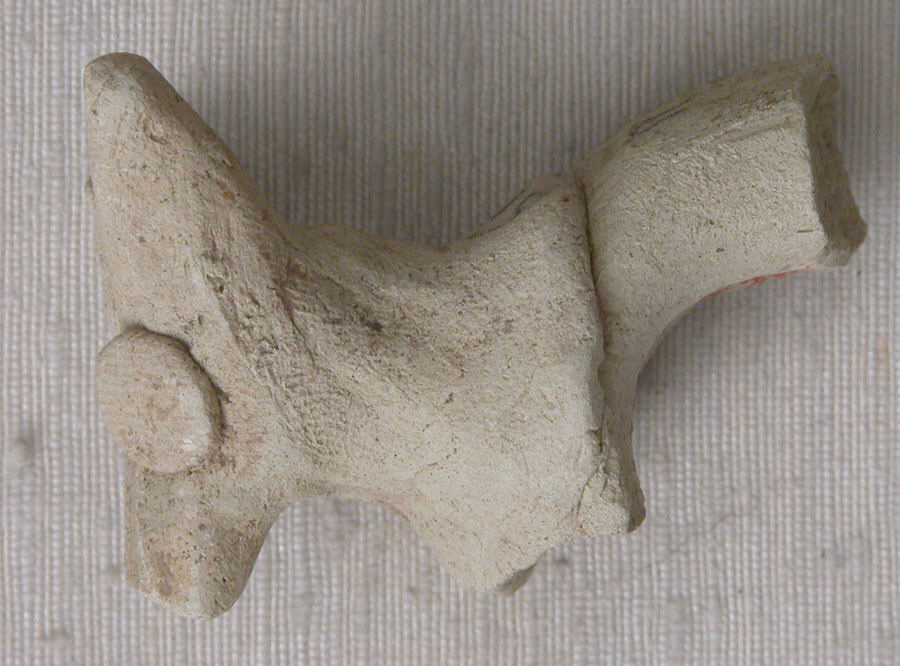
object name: fragment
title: Ceramic Fragment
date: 701-900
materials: earthenware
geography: iraq